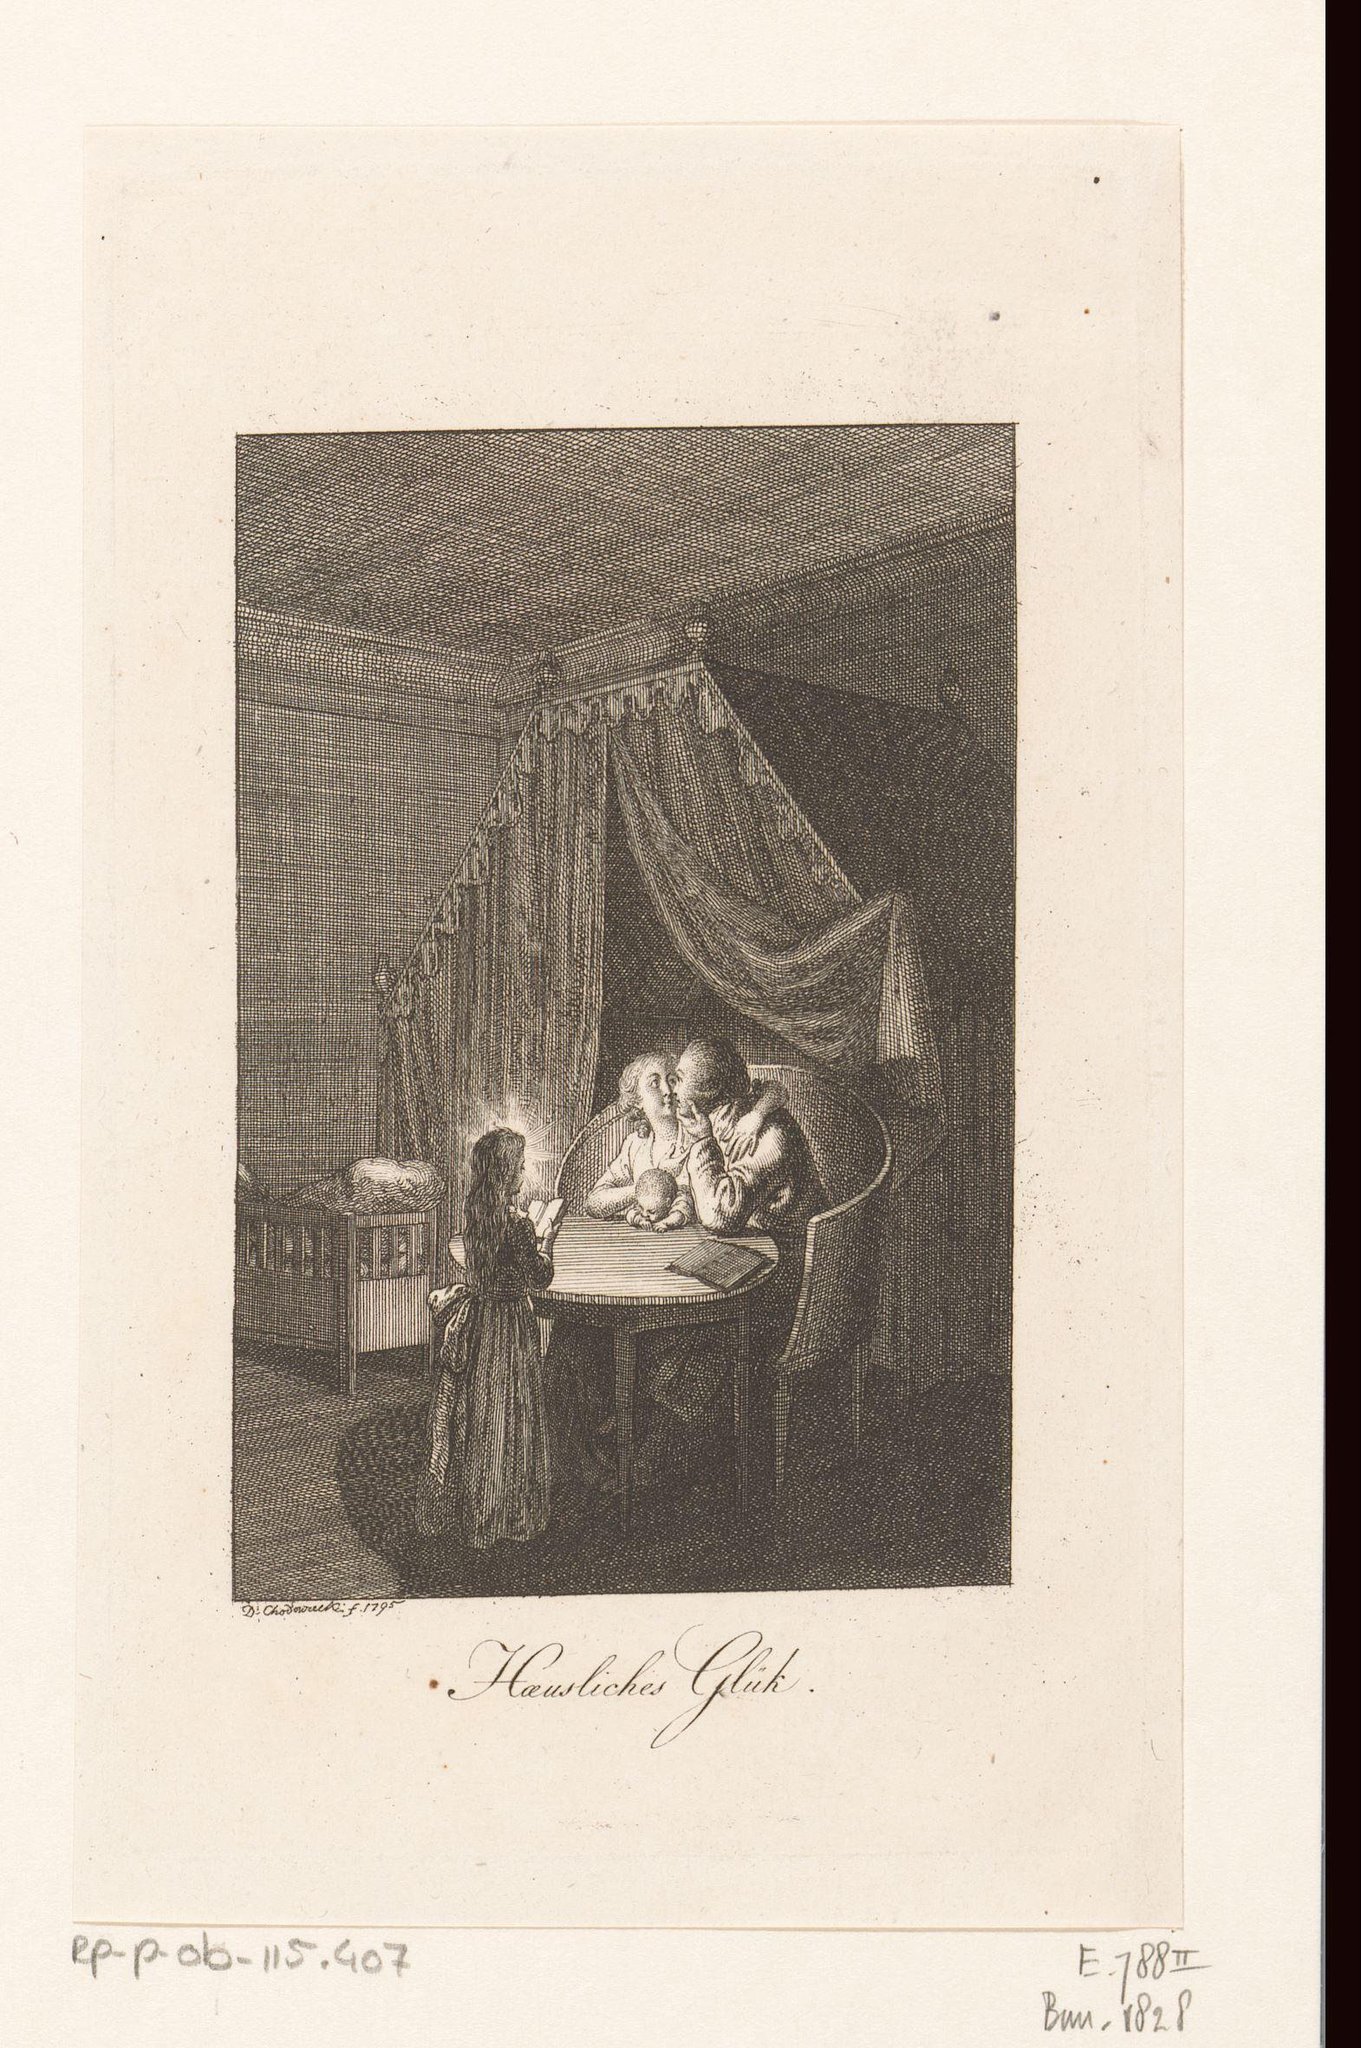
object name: print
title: Gelukkig koppel met hun gezin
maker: daniel nikolaus chodowiecki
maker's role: draughtsman, print maker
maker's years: 1726-1801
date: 1795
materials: paper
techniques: etching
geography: berlin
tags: parental love, happy marriage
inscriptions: collector's mark: Lugt 2228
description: Prent gebruikt voor: Lang, Carl. Almanach und Taschenbuch für Haeusliche u. Gesellschaftl. Freunden (...). [Frankfurt]: Heilbronn, 1796.